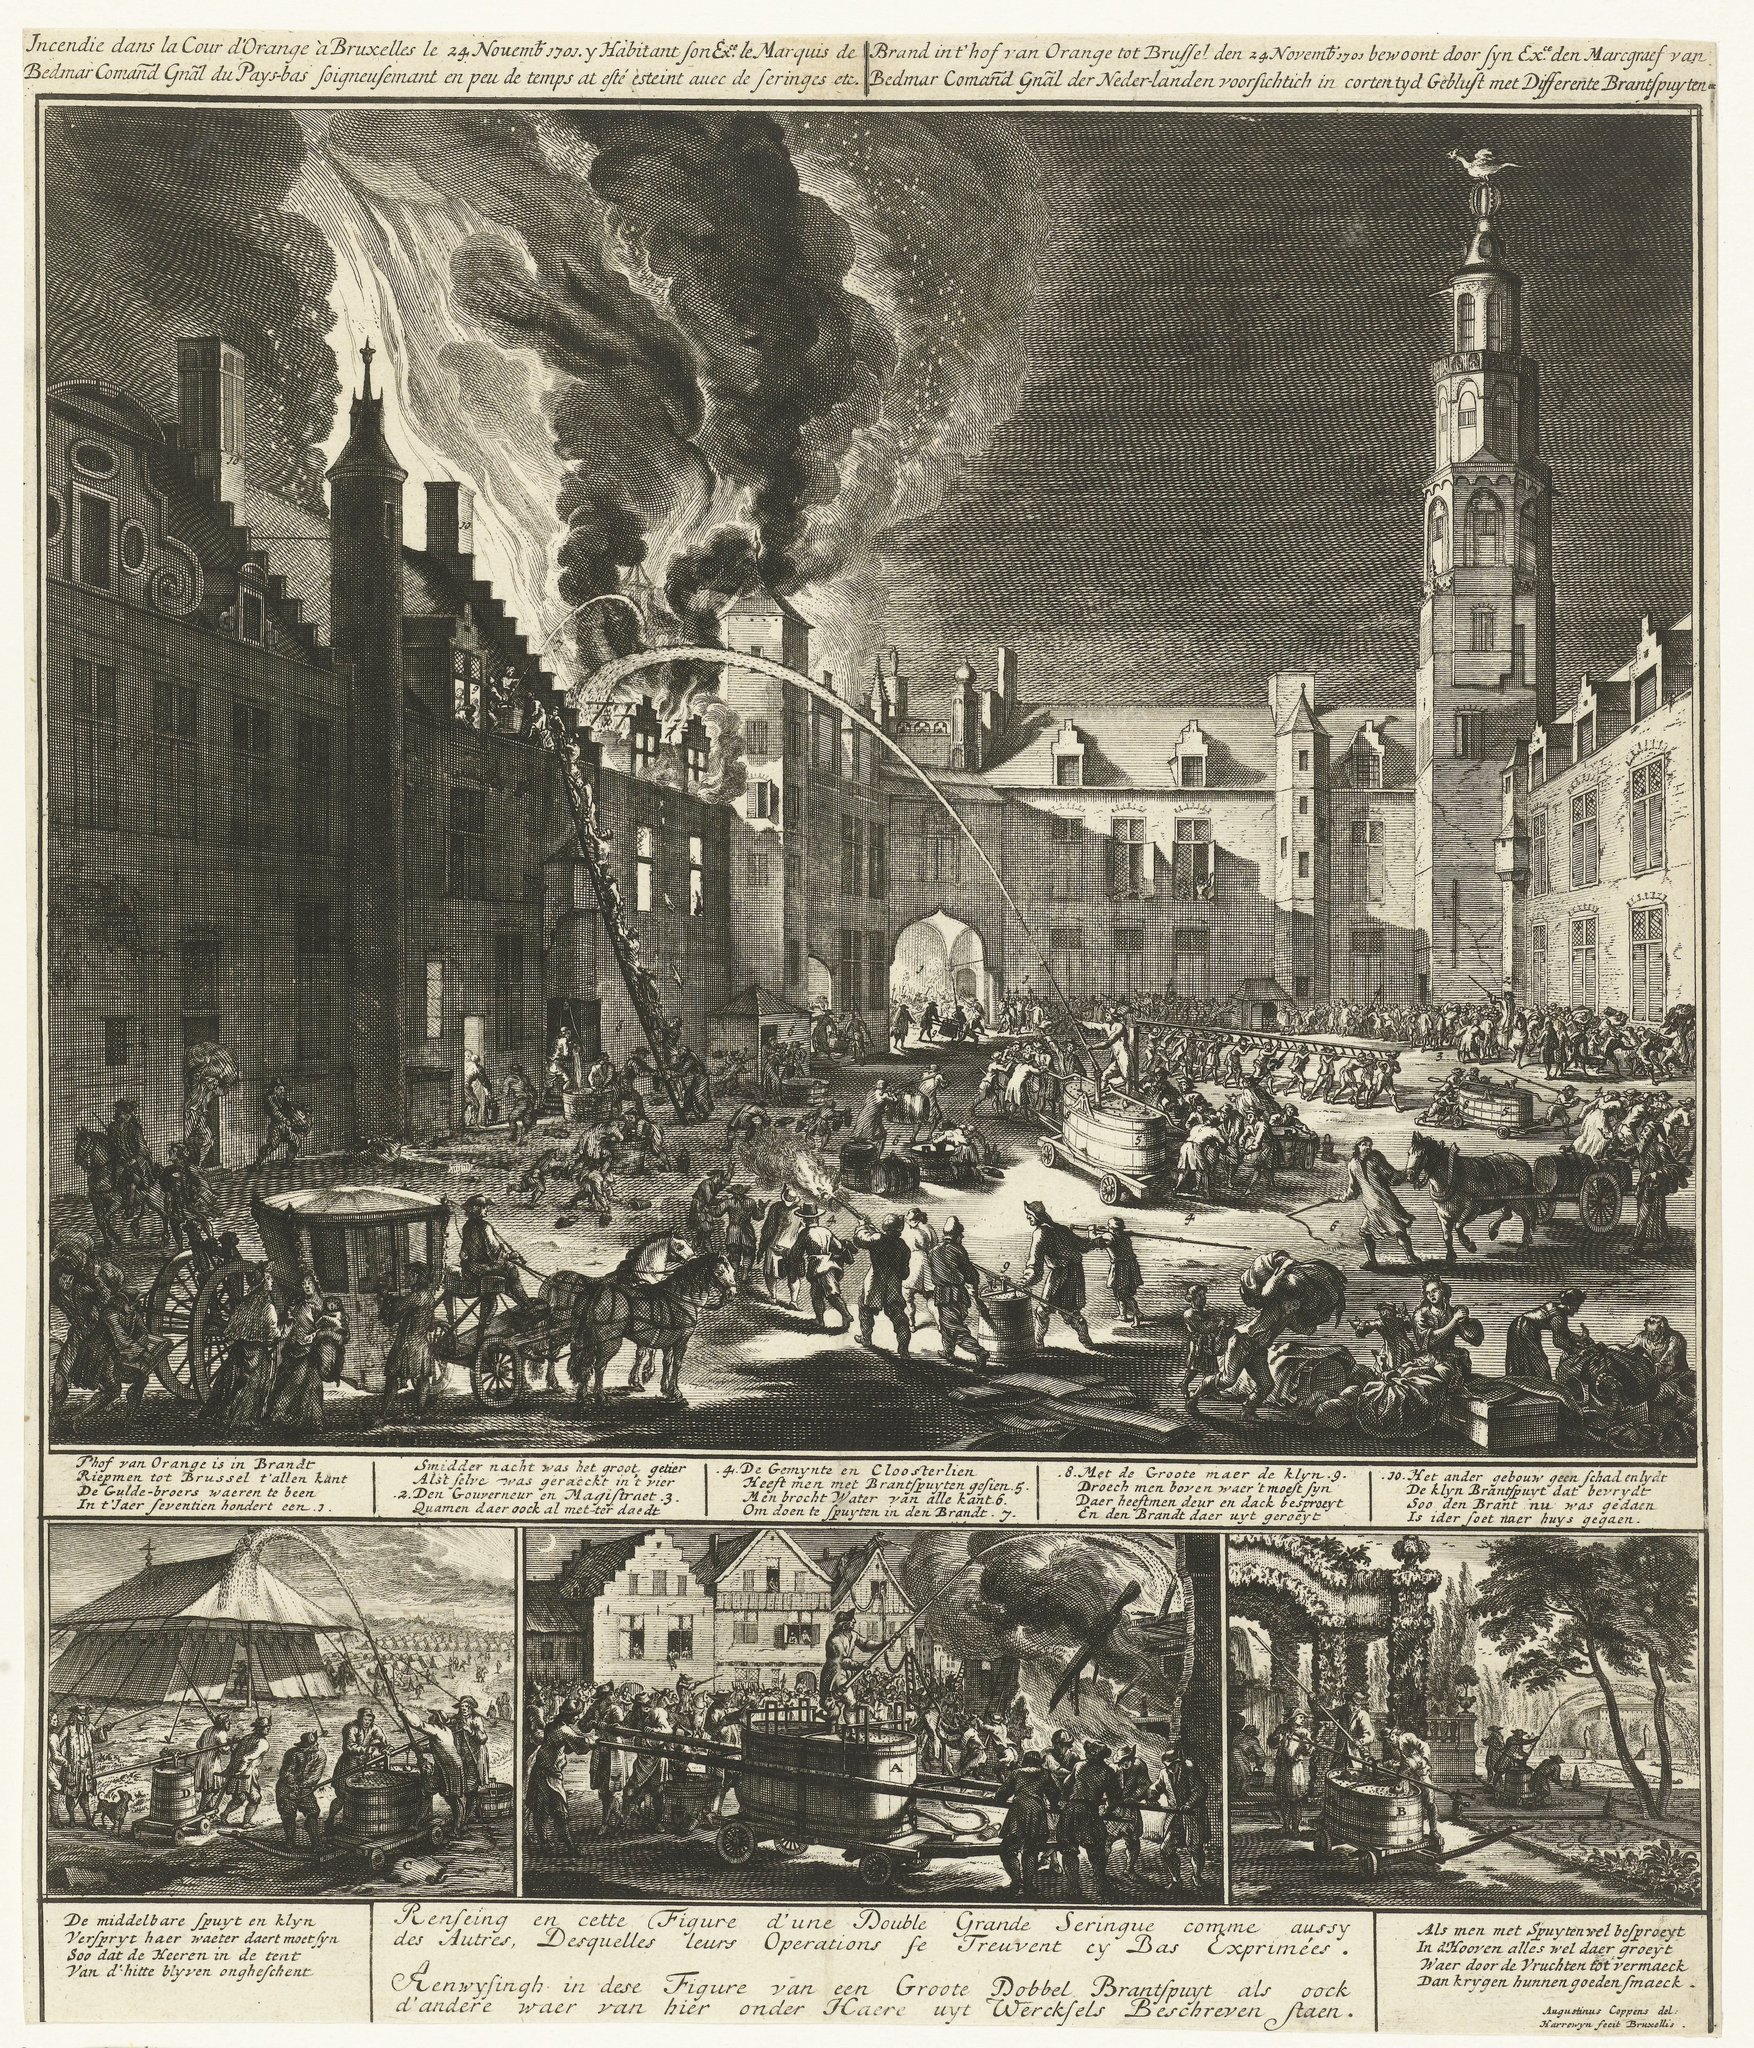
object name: print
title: Incendie dans la Cour d'Orange à Bruxelles le 24 Novemb 1701, y Habitant son Exce. le Marquis de Bedmar Comand. Gnal. du Pays-Bas soigneusement en peu de temps at esté esteint avec de seringes etc.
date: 1701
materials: paper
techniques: etching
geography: brussels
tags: pump (fire-extinguishing equipment), brussels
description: Nachtvoorstelling van het blussen van de brand met brandspuiten in het Hof van Oranje te Brussel, 24 november 1701. Het hof was de woonplaats van Isidro de la Cueva-Benavides, markies van Bedmar, commandant van de Spaanse troepen in de Zuidelijke Nederlanden. Onderaan drie kleine plaatjes van andere mogelijke toepassingen van de brandspuiten met begeleidende verzen in het Nederlands.